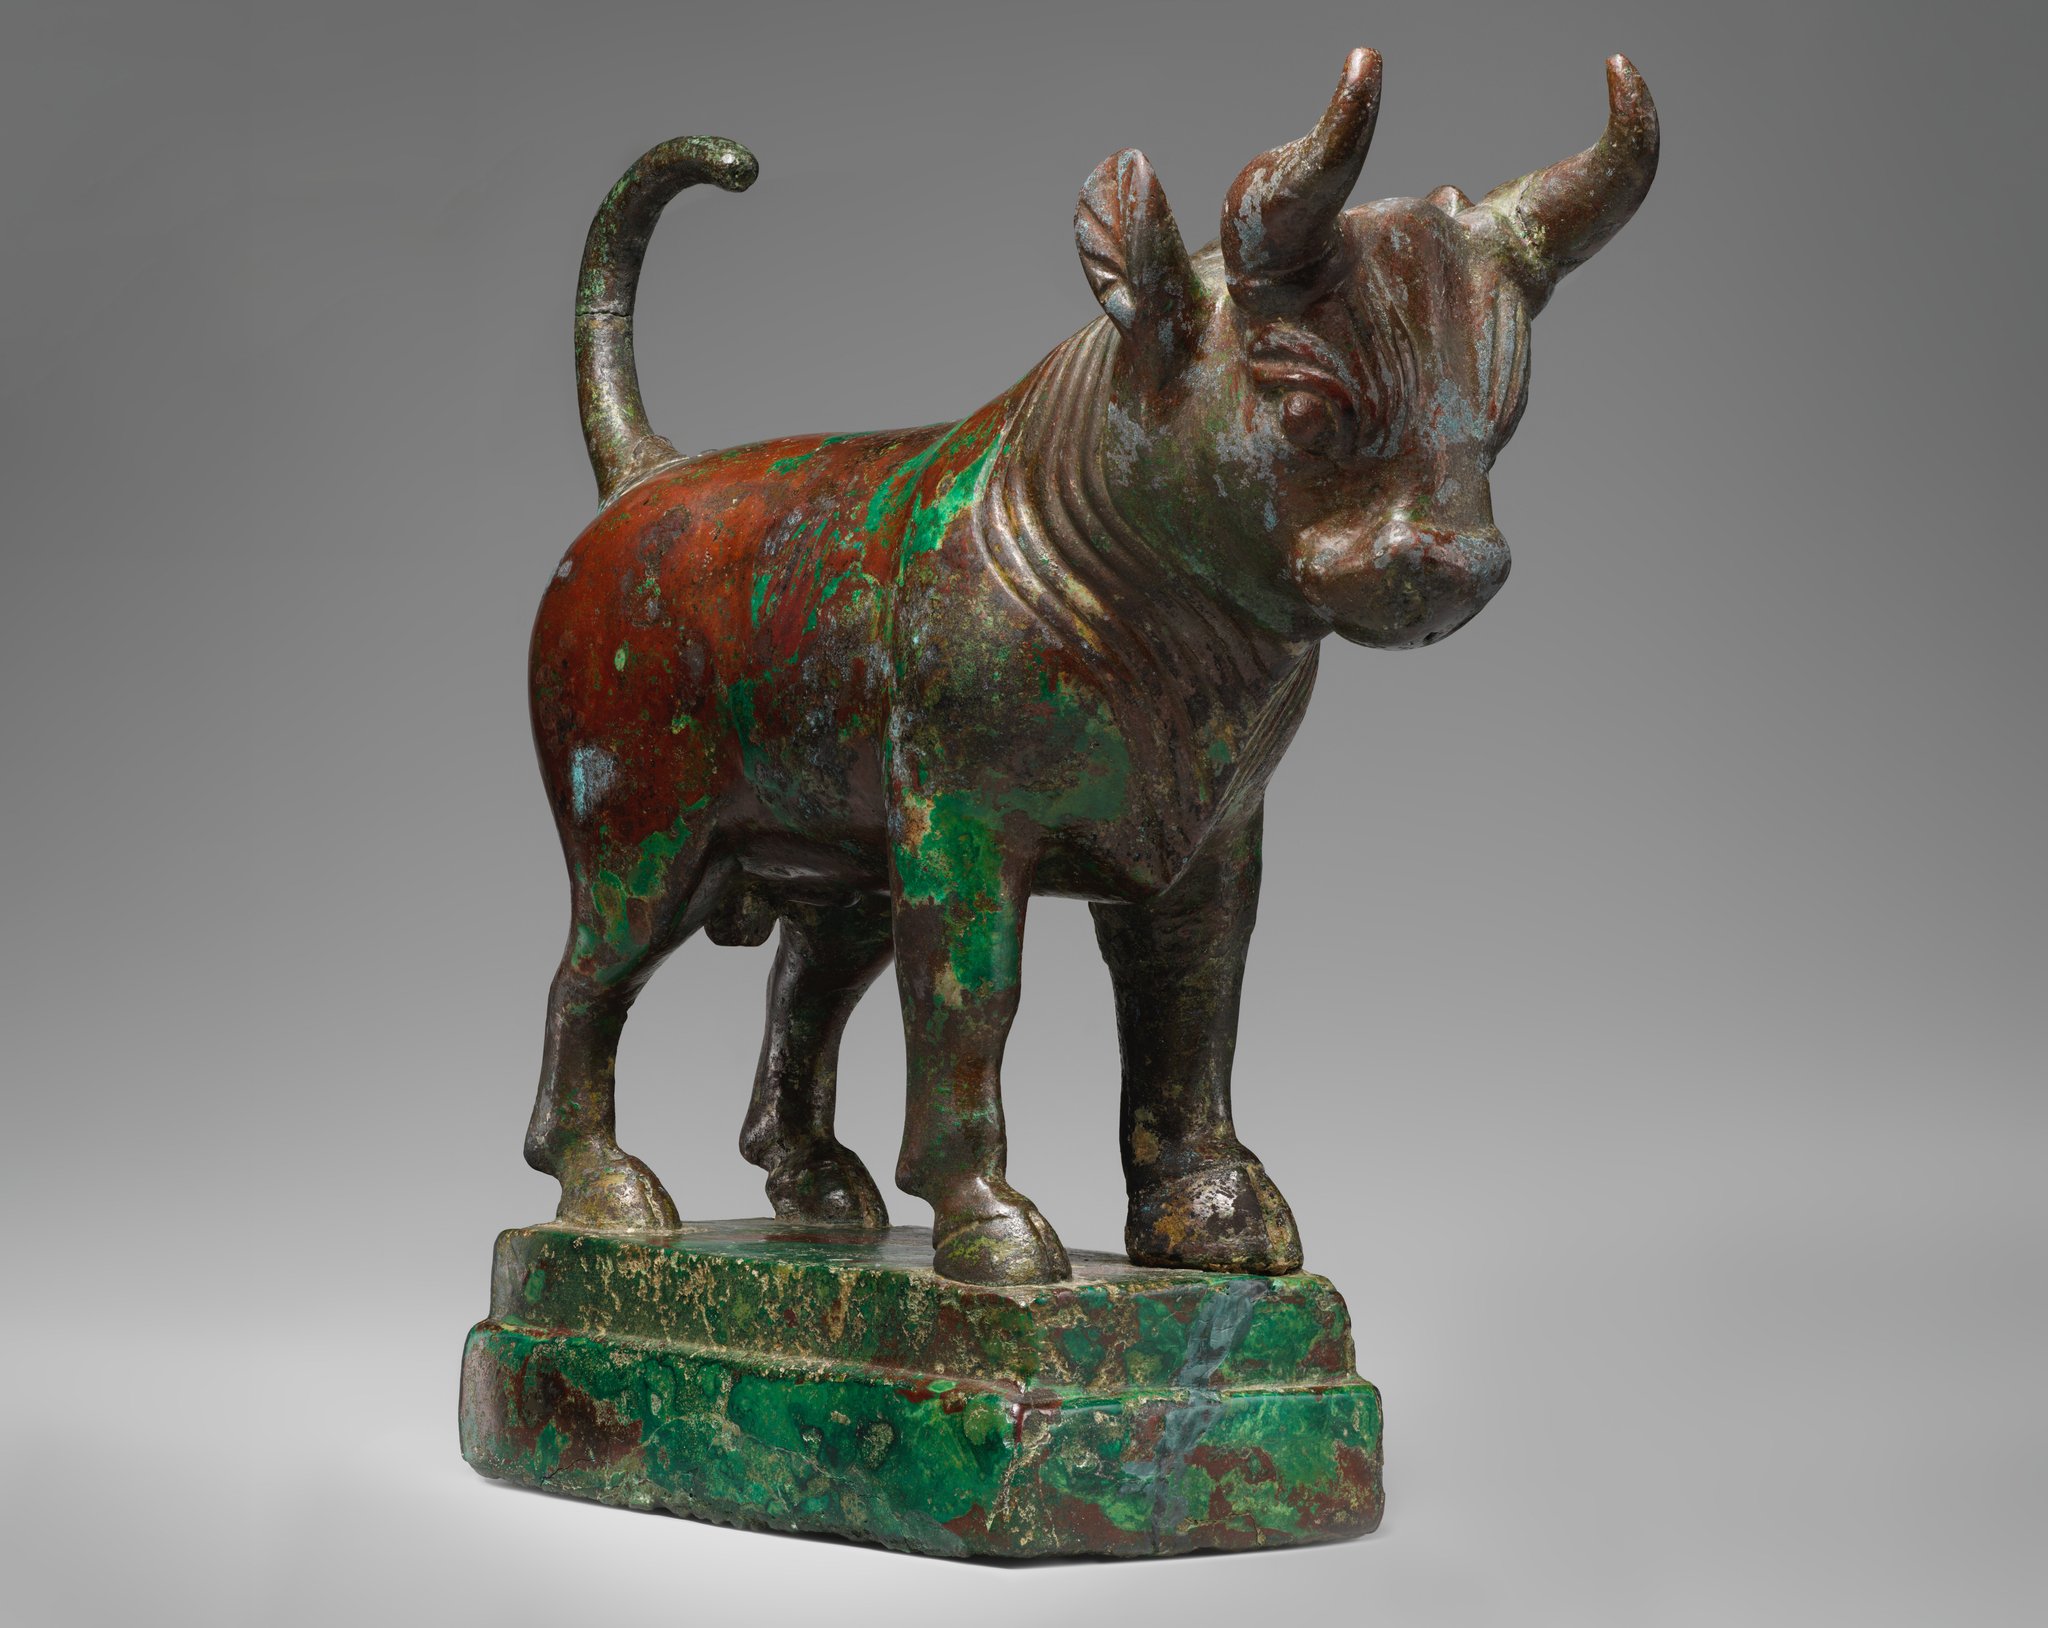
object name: sculpture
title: Standing bull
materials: bronze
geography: southwestern arabia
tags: bulls